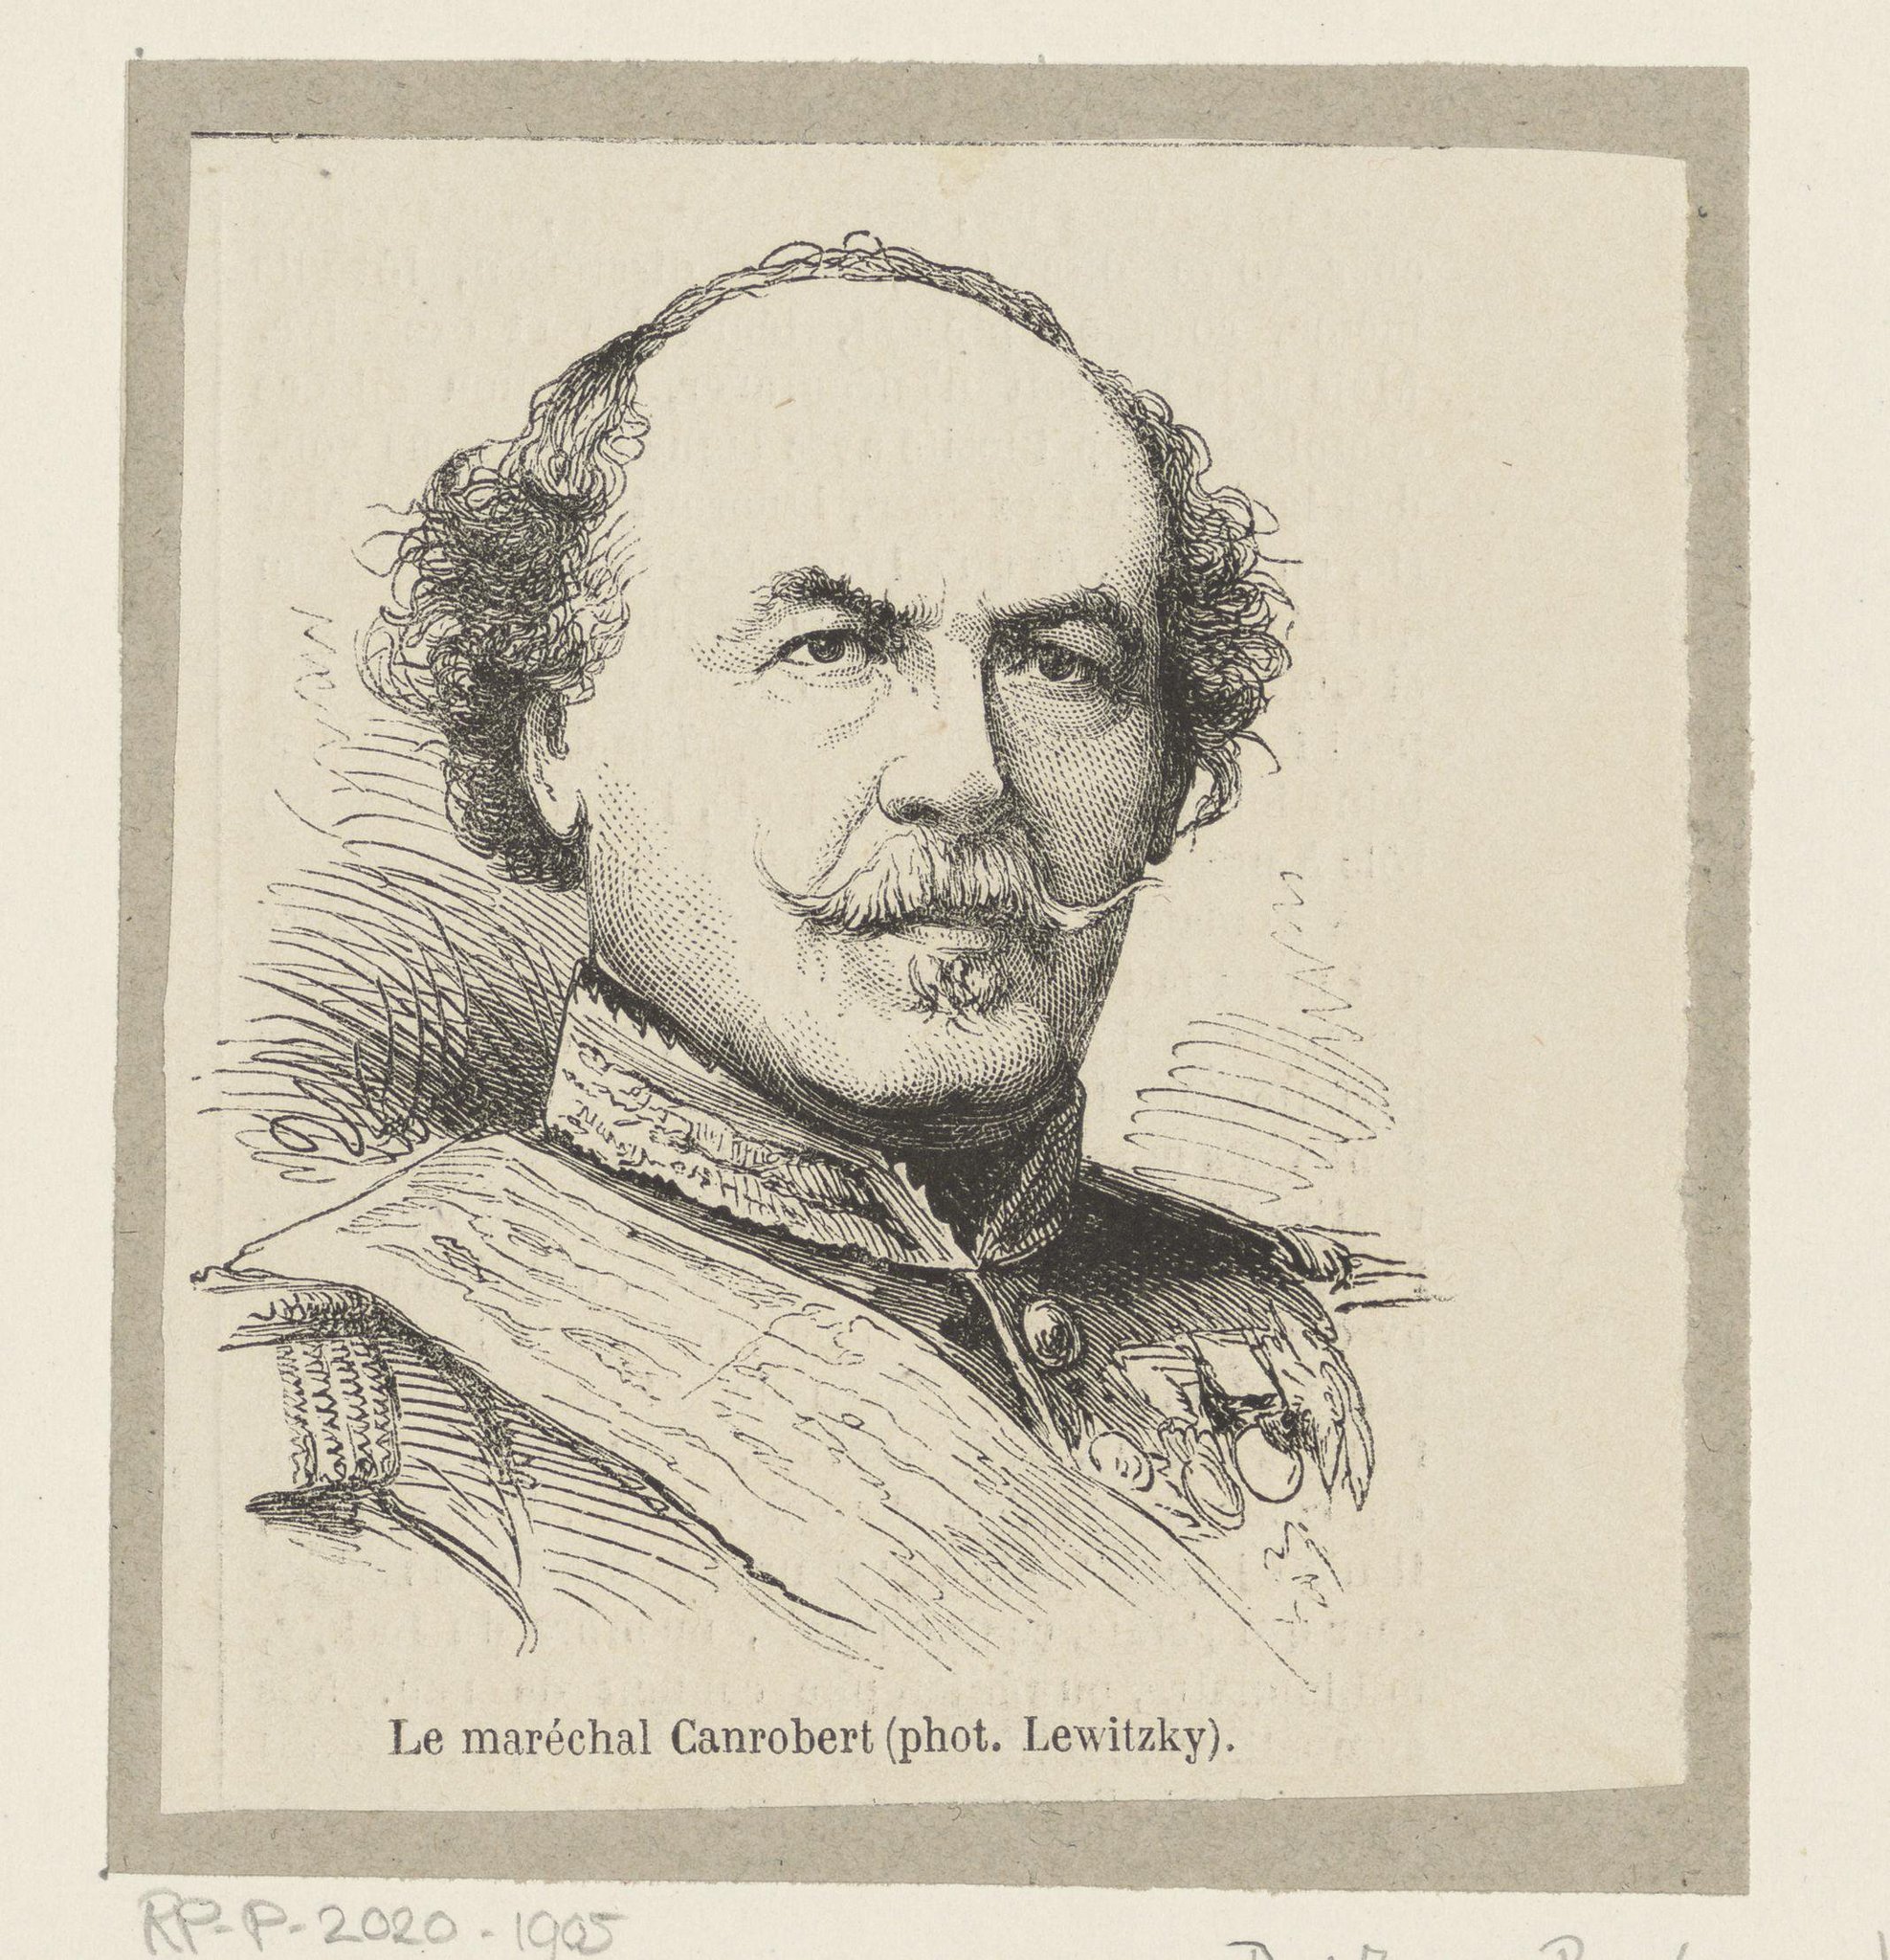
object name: print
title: Portret van François Certain Canrobert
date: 1872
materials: paper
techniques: engraving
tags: historical persons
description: Prent mogelijk uit: L'Illustration, journal universel, 1872.